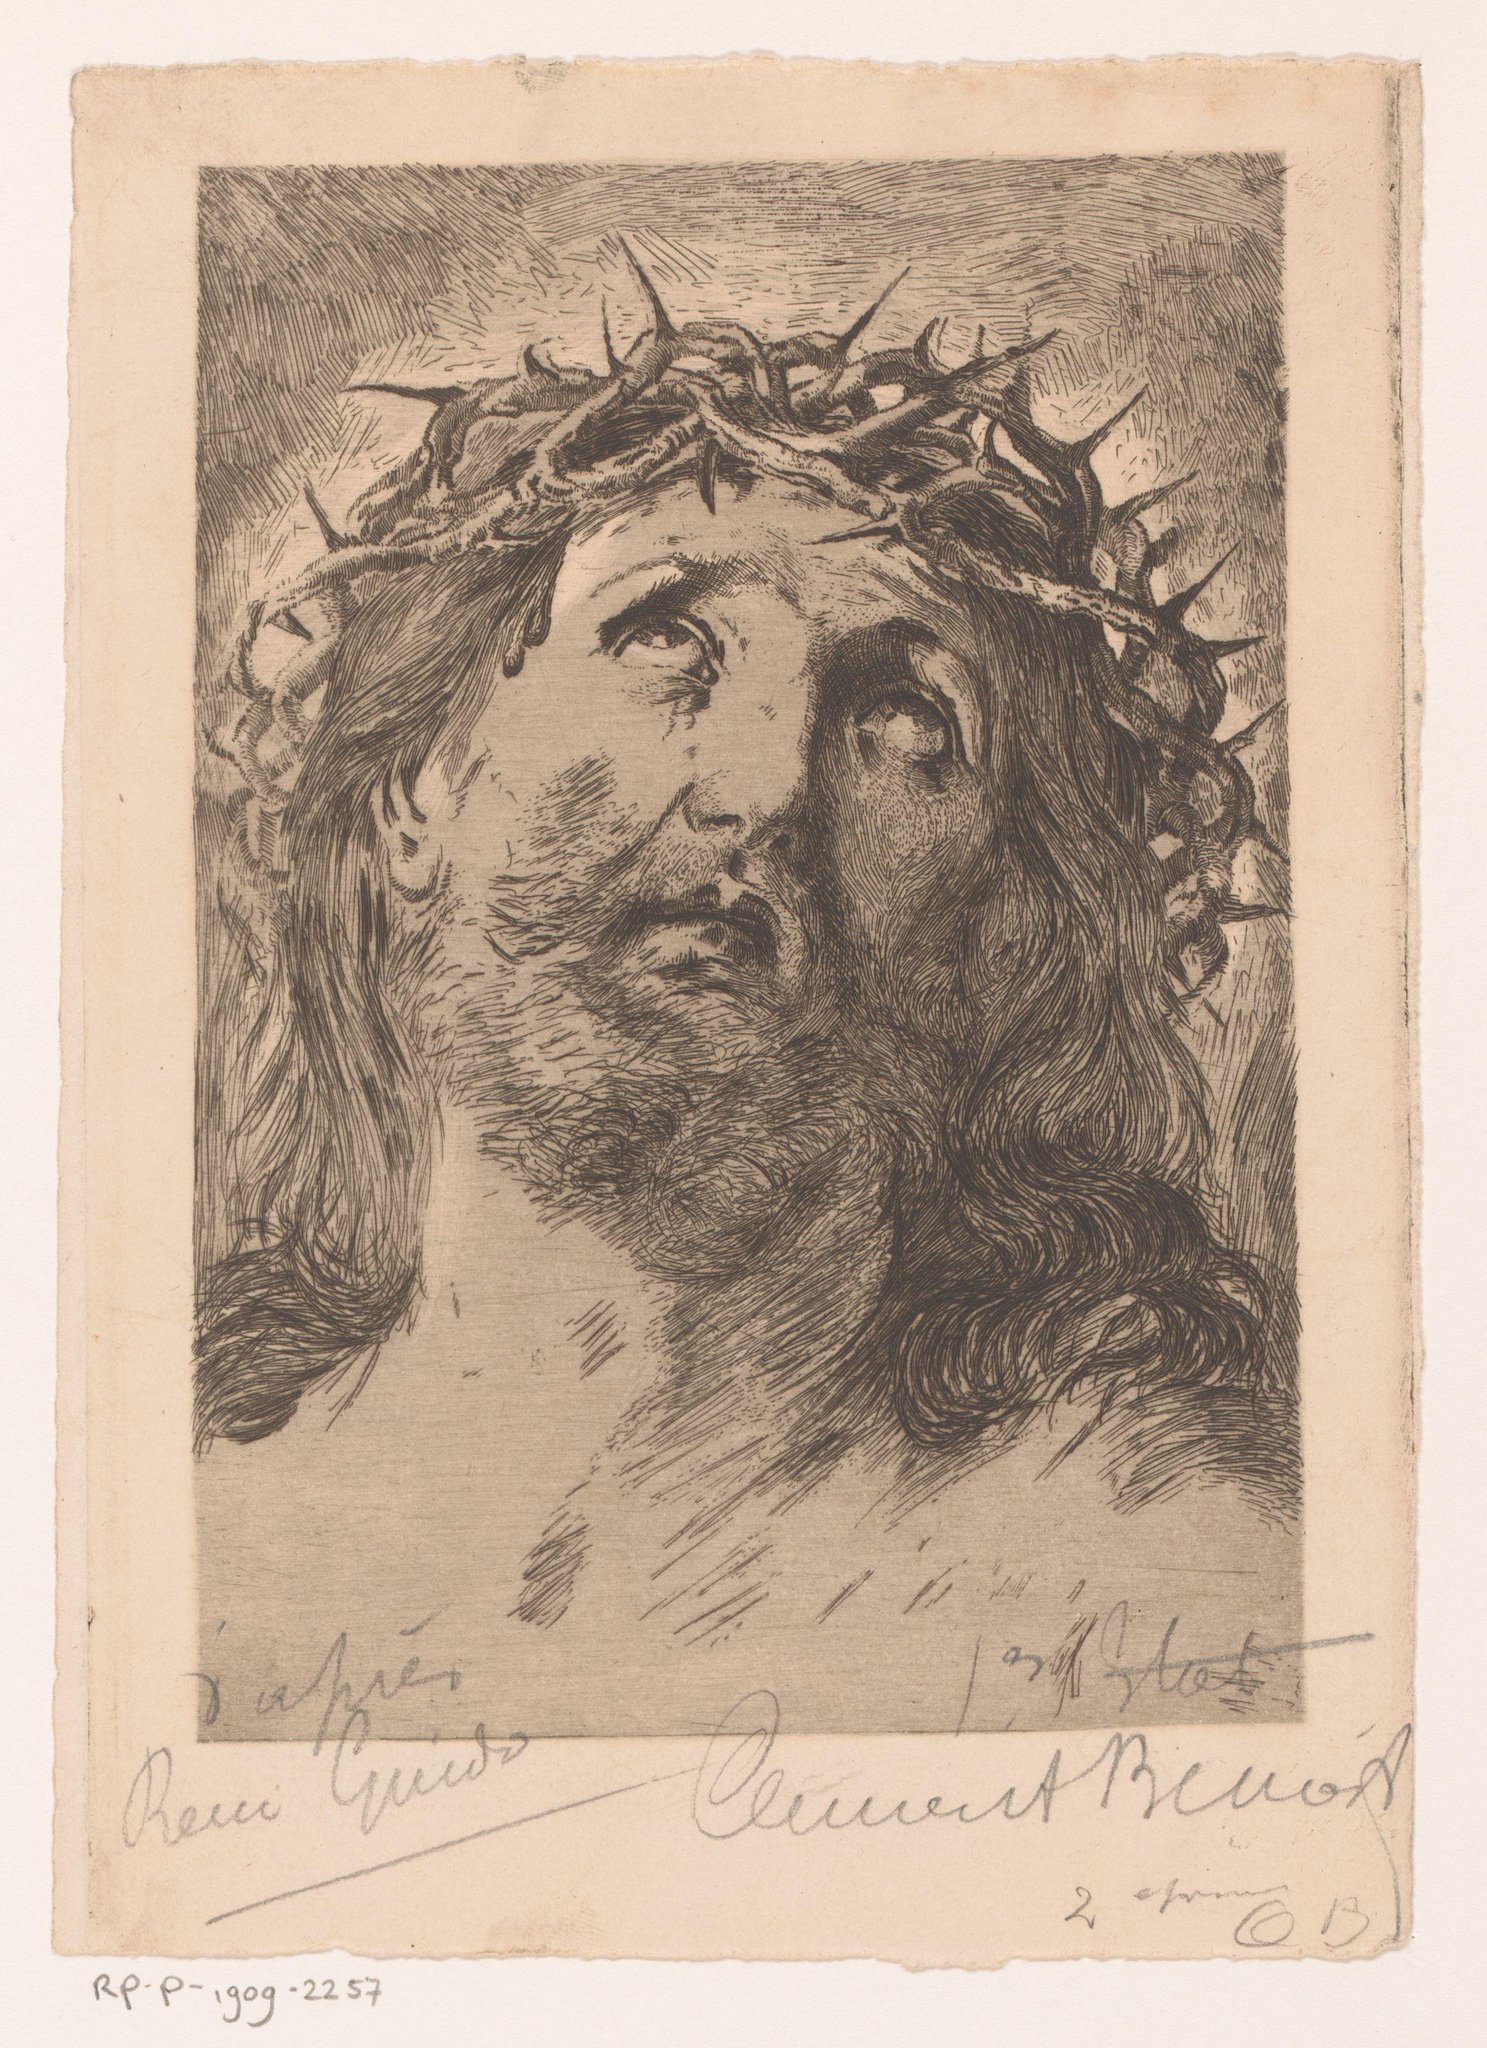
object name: print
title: Christus met doornenkroon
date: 1876-1909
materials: paper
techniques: etching, intaglio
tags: head of christ with crown of thorns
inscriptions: collector's mark: Lugt 2228